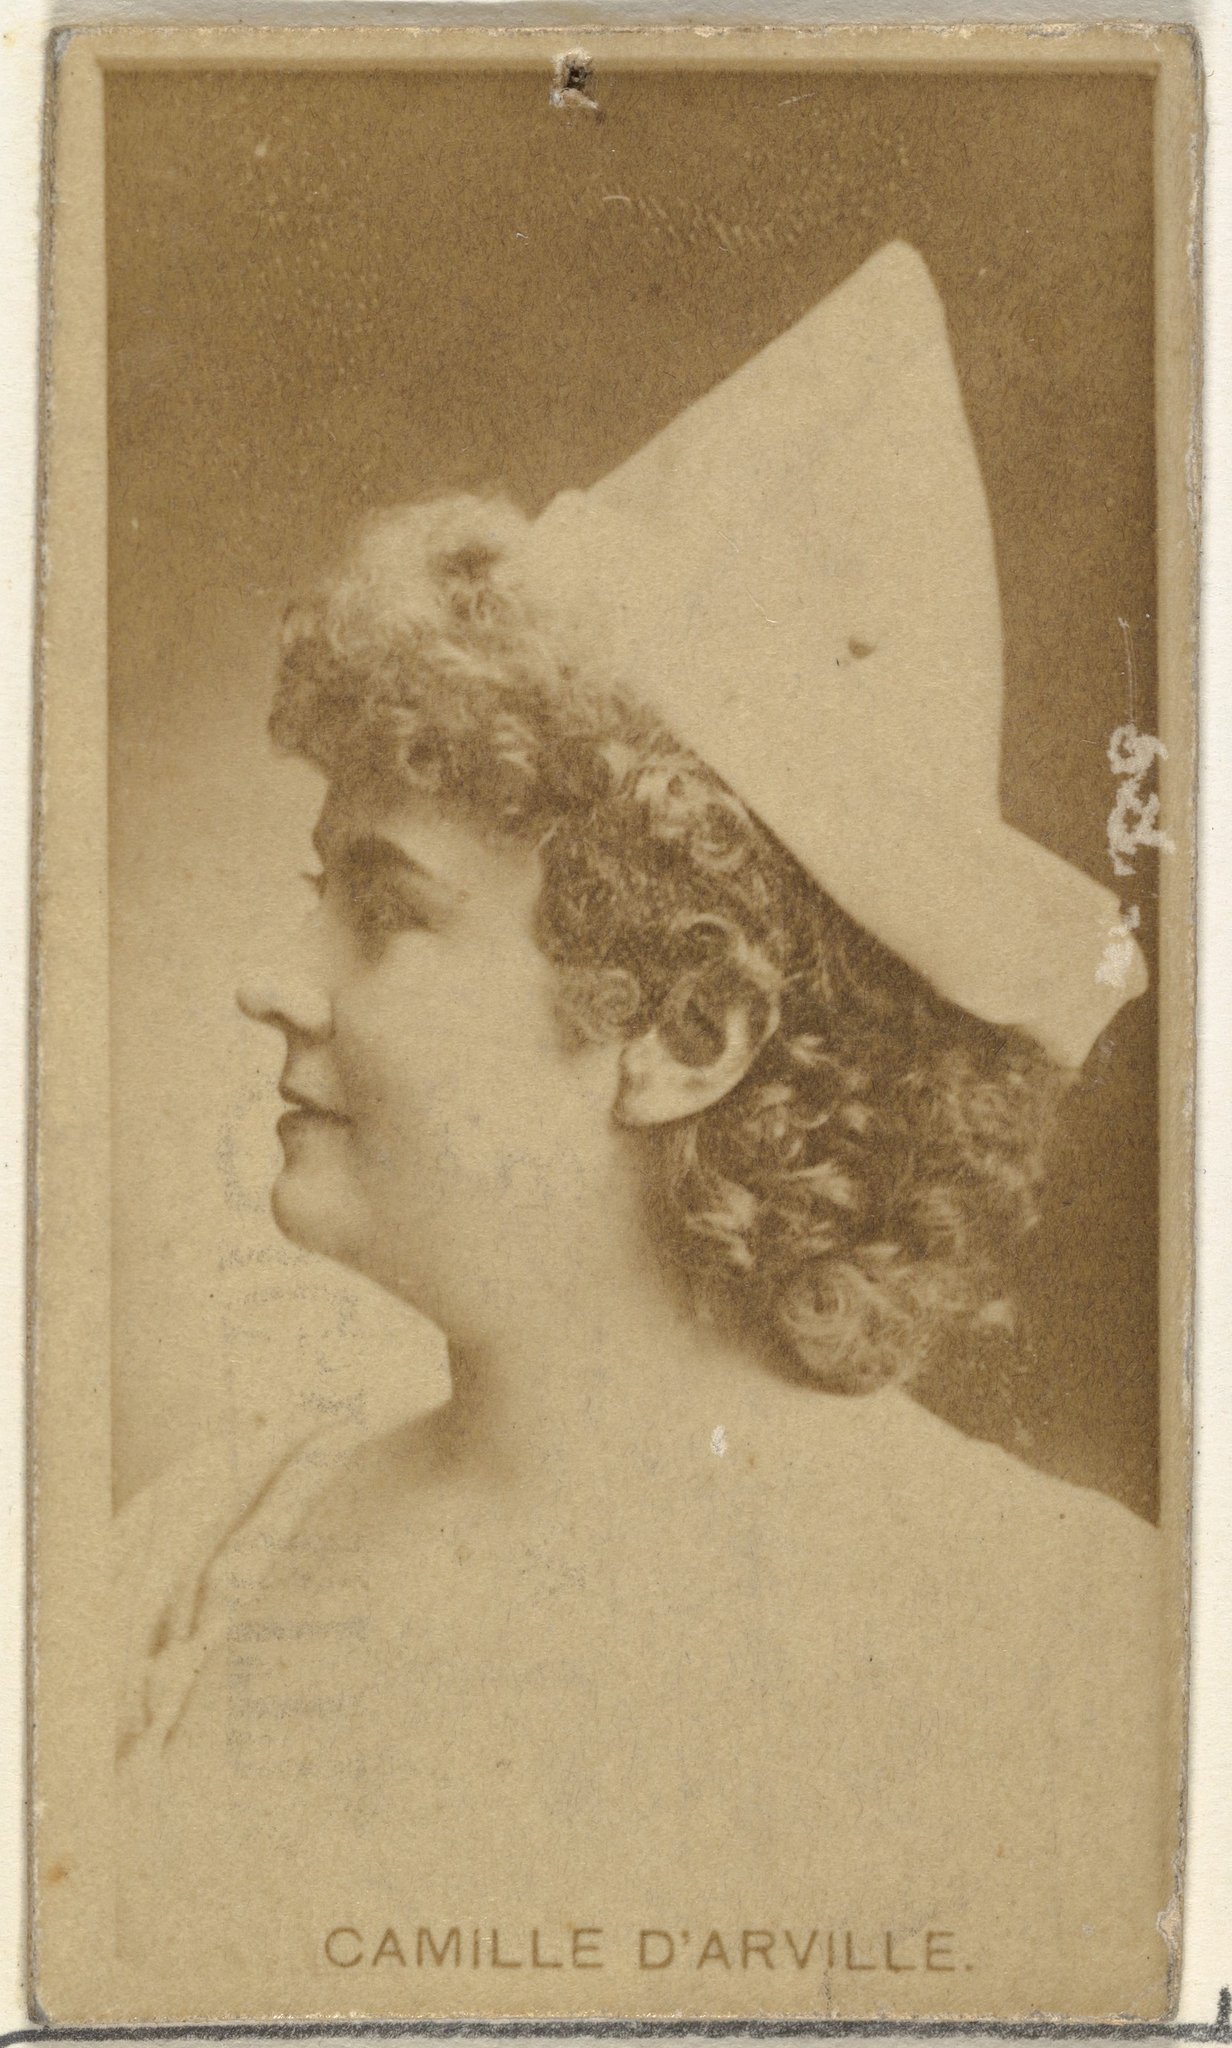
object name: photograph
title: Camille D'arville, from the Actors and Actresses series (N145-8) issued by Duke Sons & Co. to promote Duke Cigarettes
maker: w. duke, sons & co.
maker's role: publisher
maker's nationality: american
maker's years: 1870-1920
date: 1891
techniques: albumen silver print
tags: portraits,women,actresses